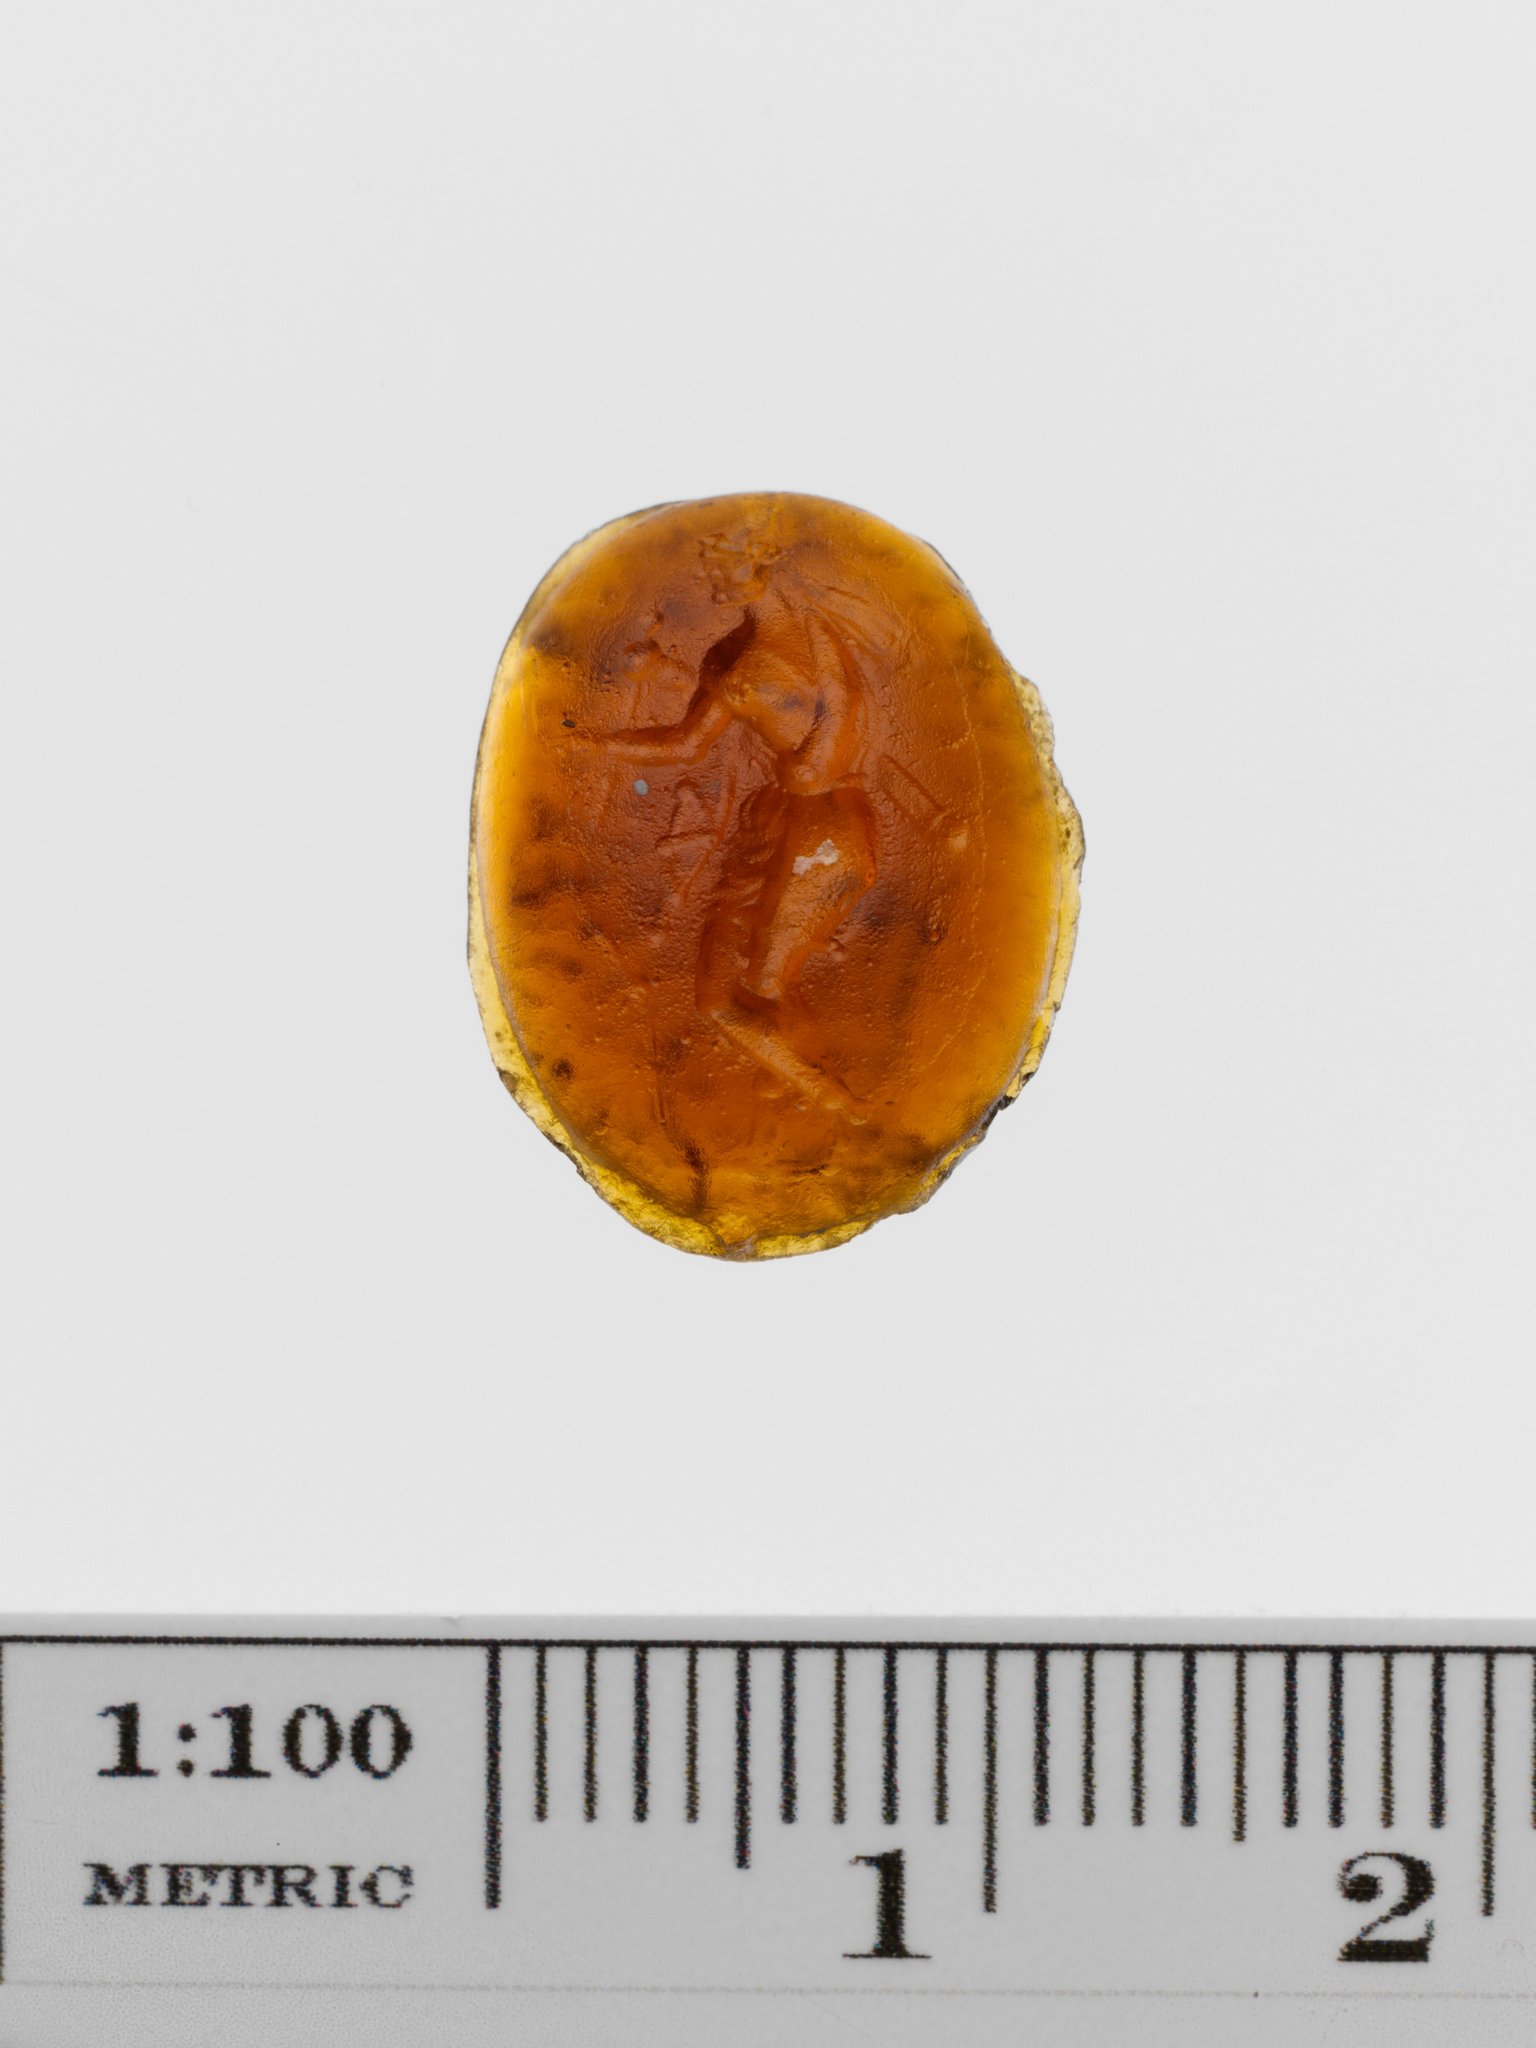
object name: intaglio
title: Glass ring stone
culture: italic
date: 300-101 BCE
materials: glass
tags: men,odysseus